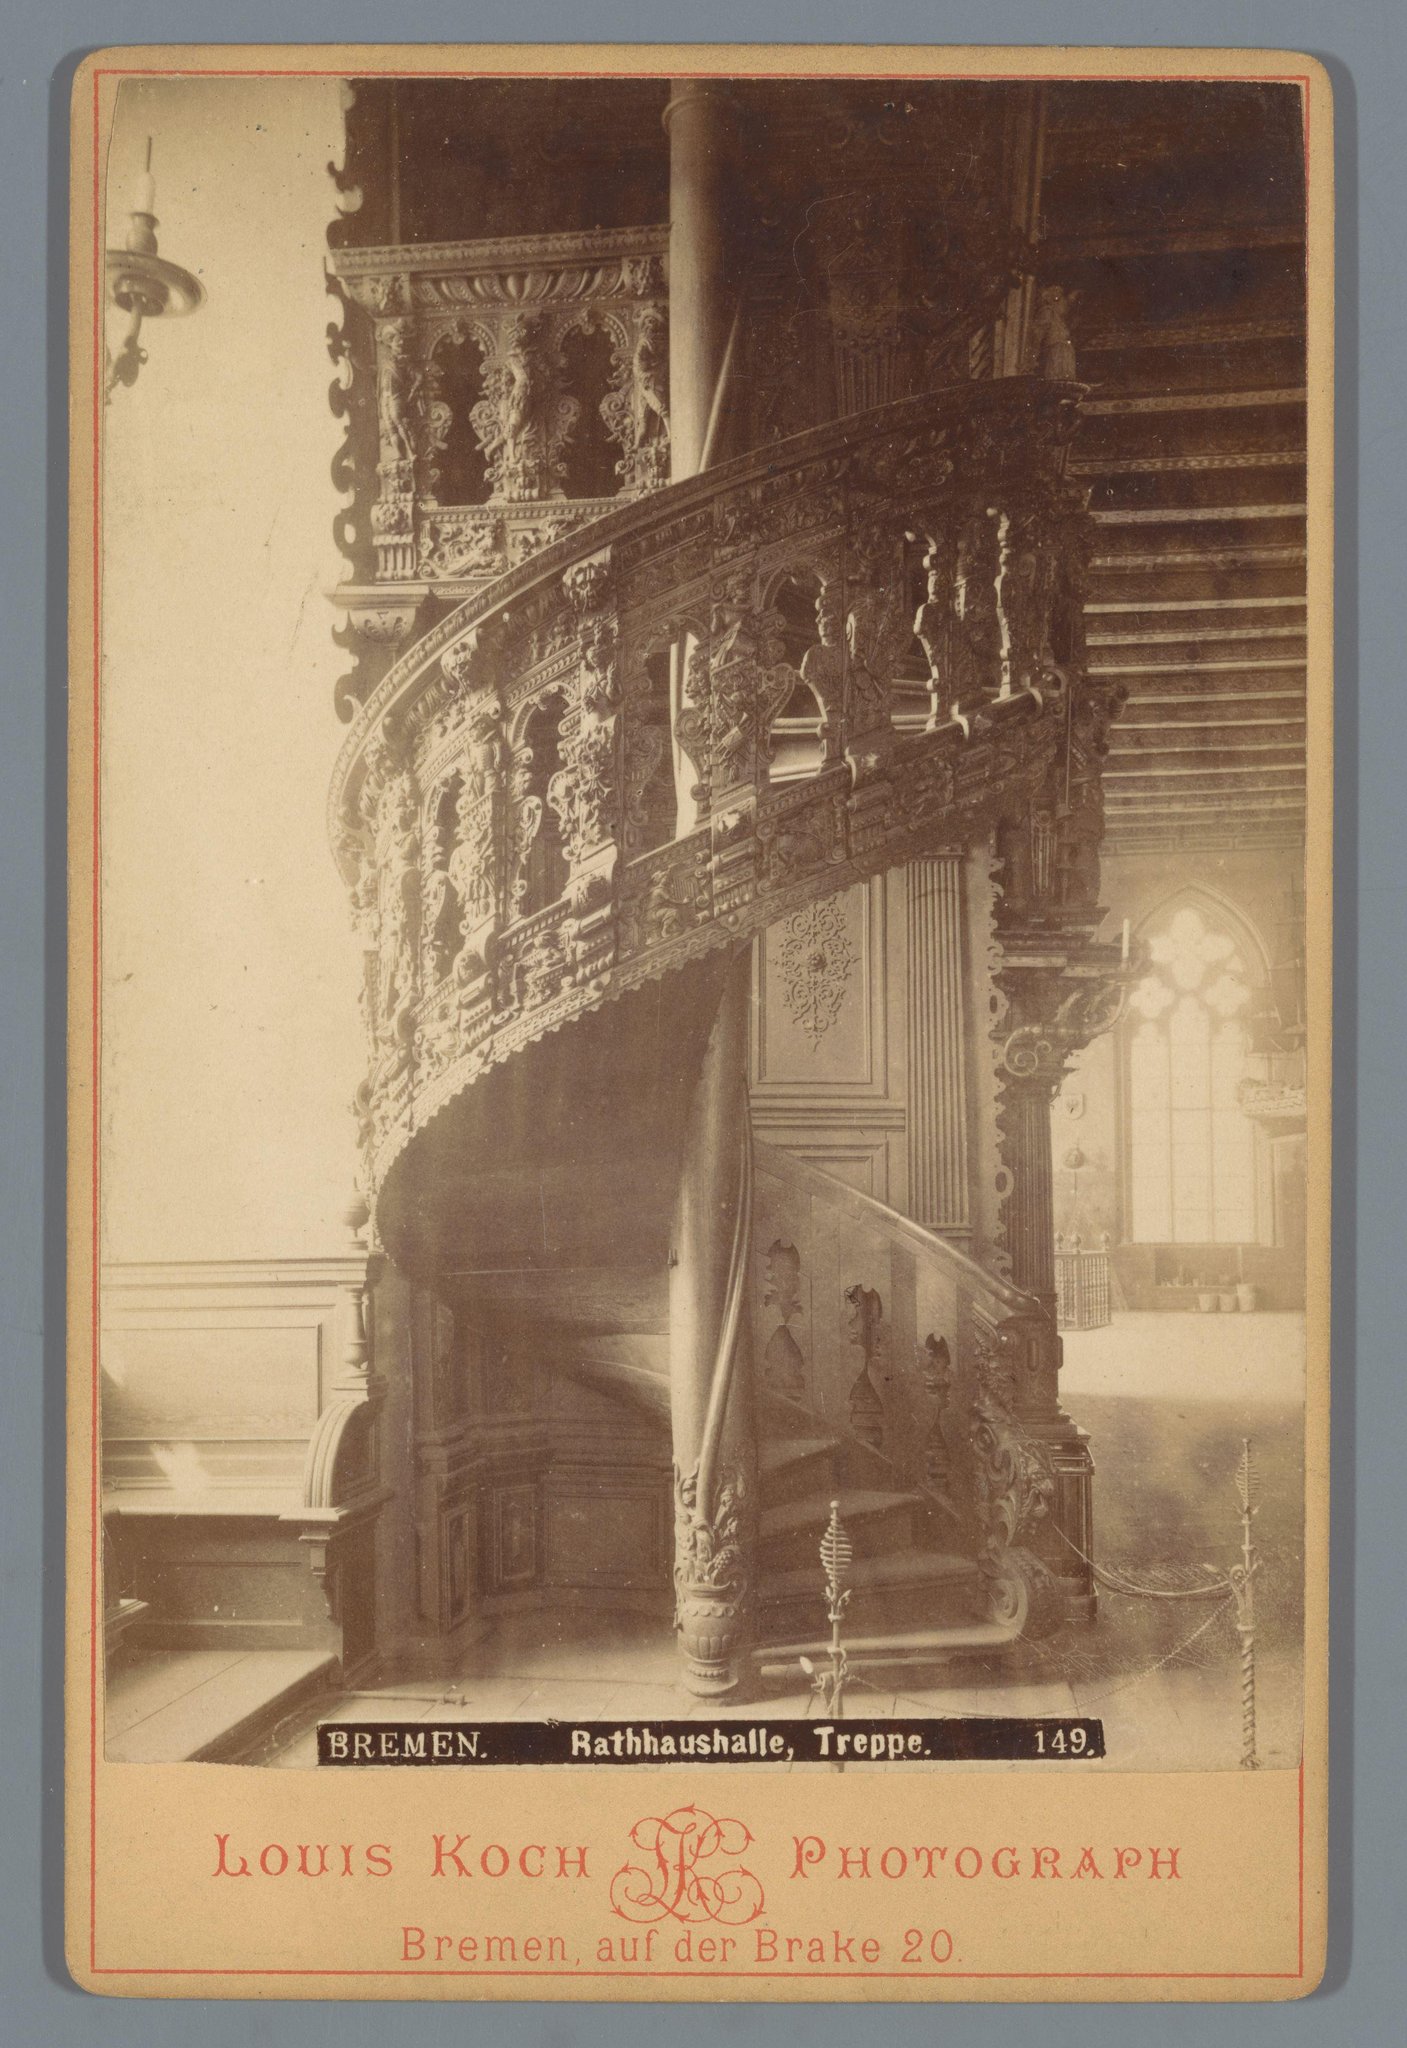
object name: photograph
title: Rathhaushalle, Treppe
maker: louis koch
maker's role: fotograaf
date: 1880-1900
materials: cardboard, photographic support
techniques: albumen print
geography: bremen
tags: townhall, staircase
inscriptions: address: ‘Bremen, auf der Brake 20.’, number: ‘149.’, workshop stamp: ‘Louis Koch/ Photographisches Atelier/ Bremen, auf der Brake No. 20/ (...)’